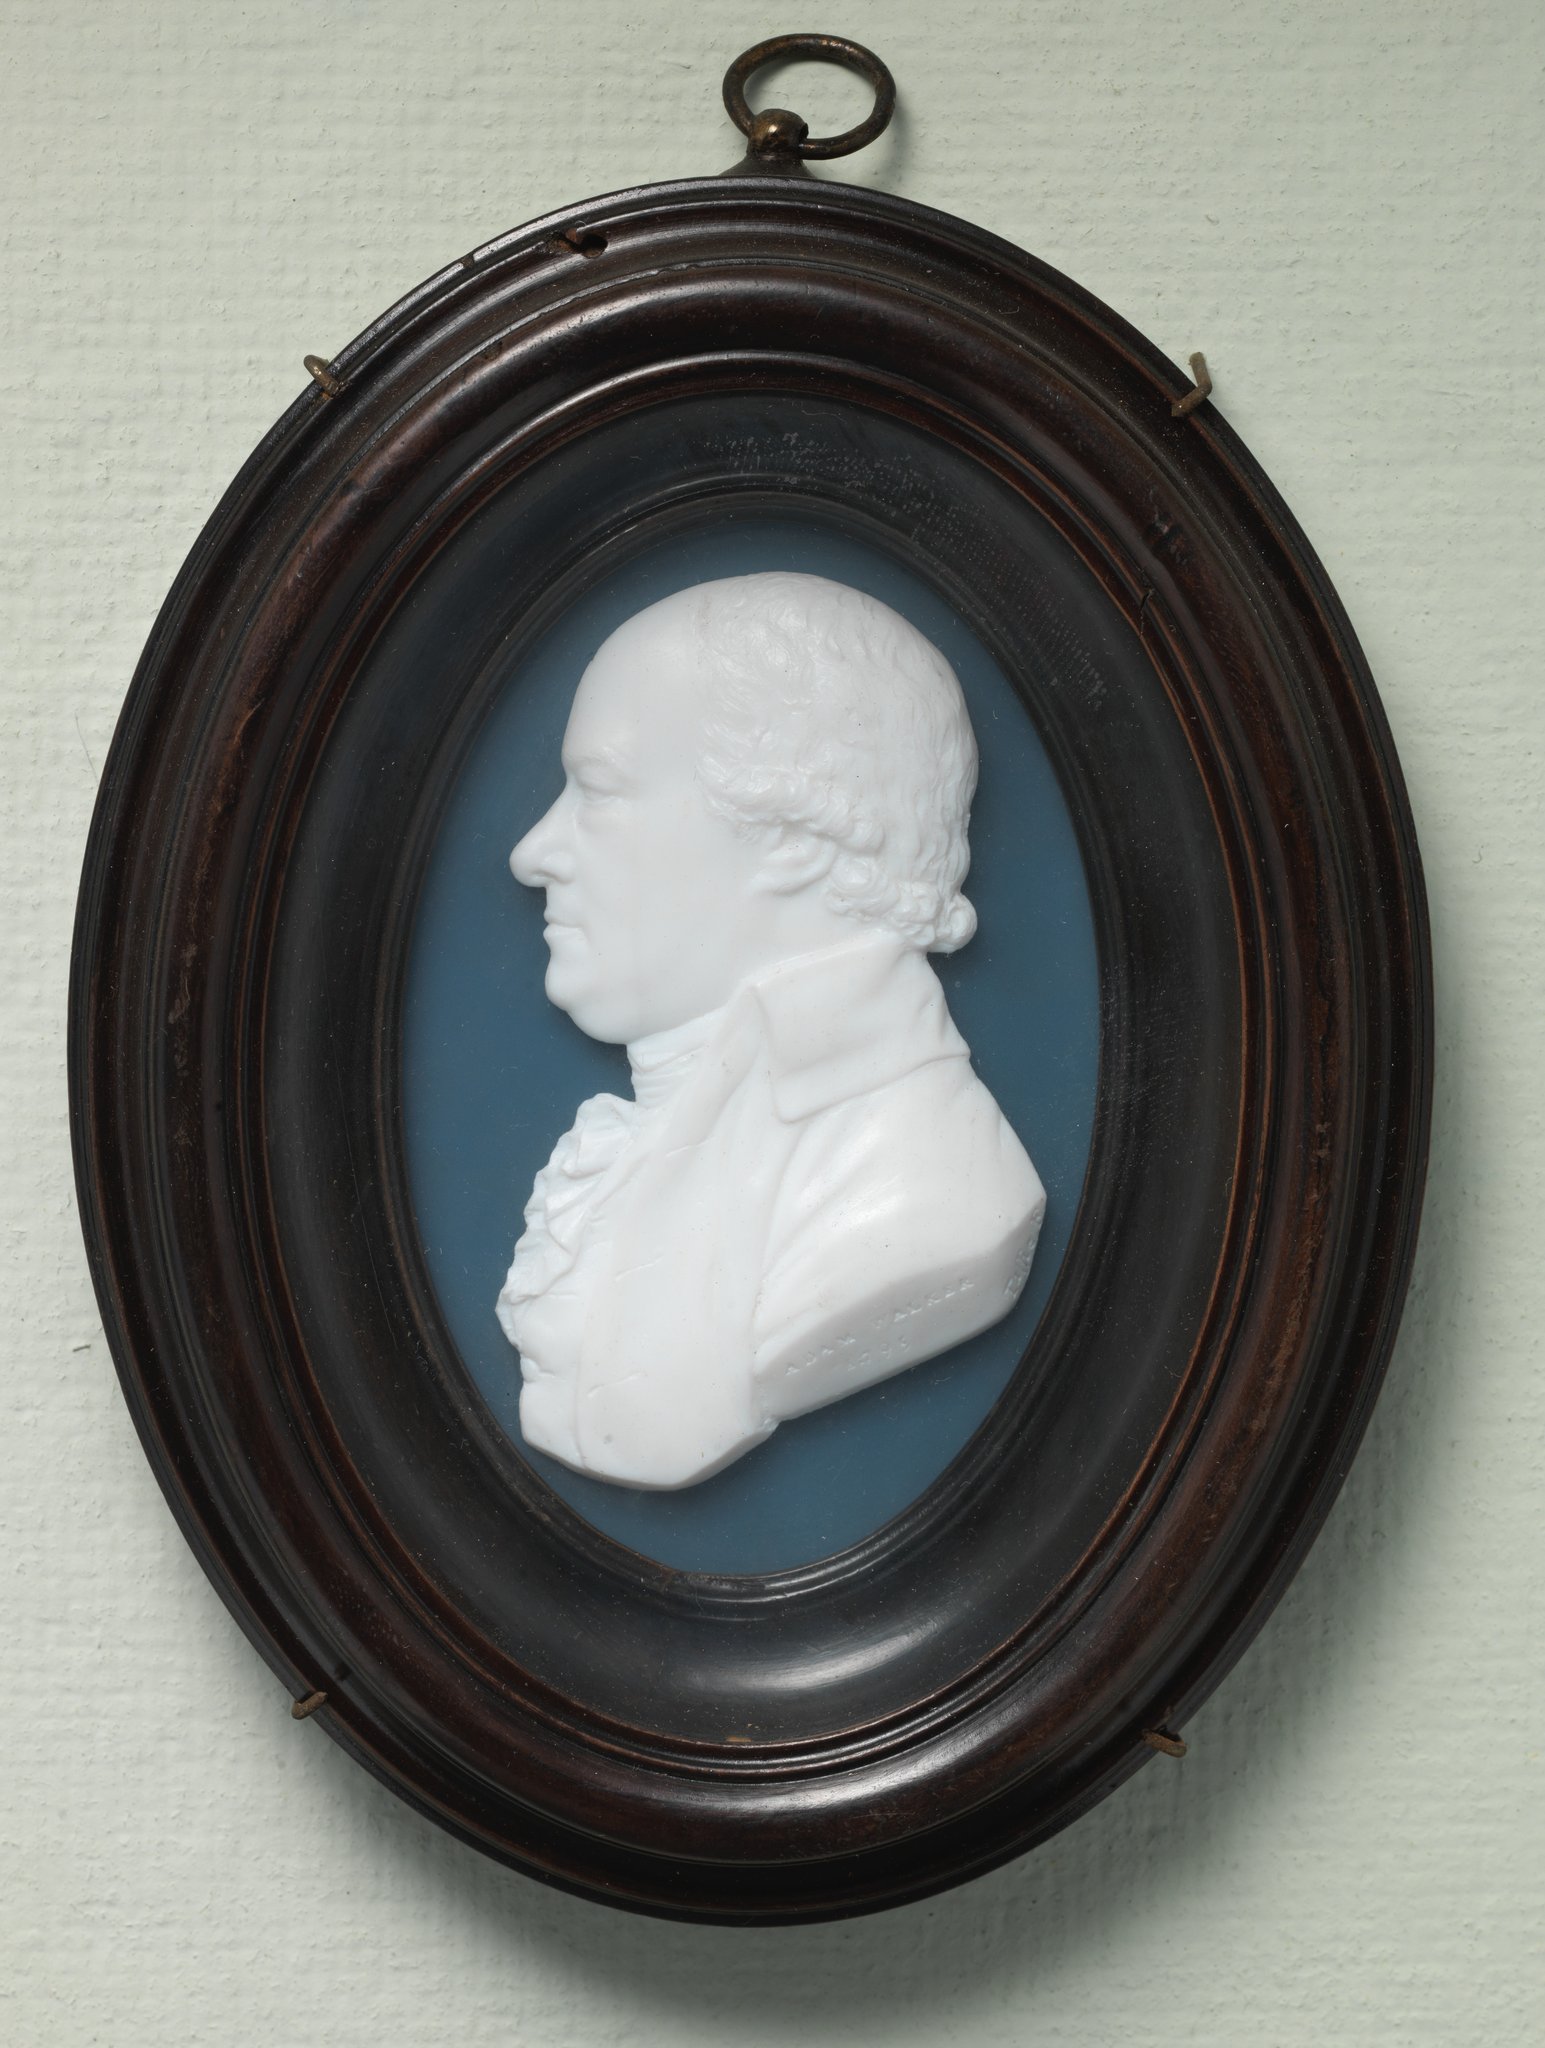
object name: medallion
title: Adam Walker (1731–1821)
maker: james tassie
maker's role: artist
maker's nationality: british, scottish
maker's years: 1735-1799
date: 1795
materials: glass, paste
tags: men,profiles